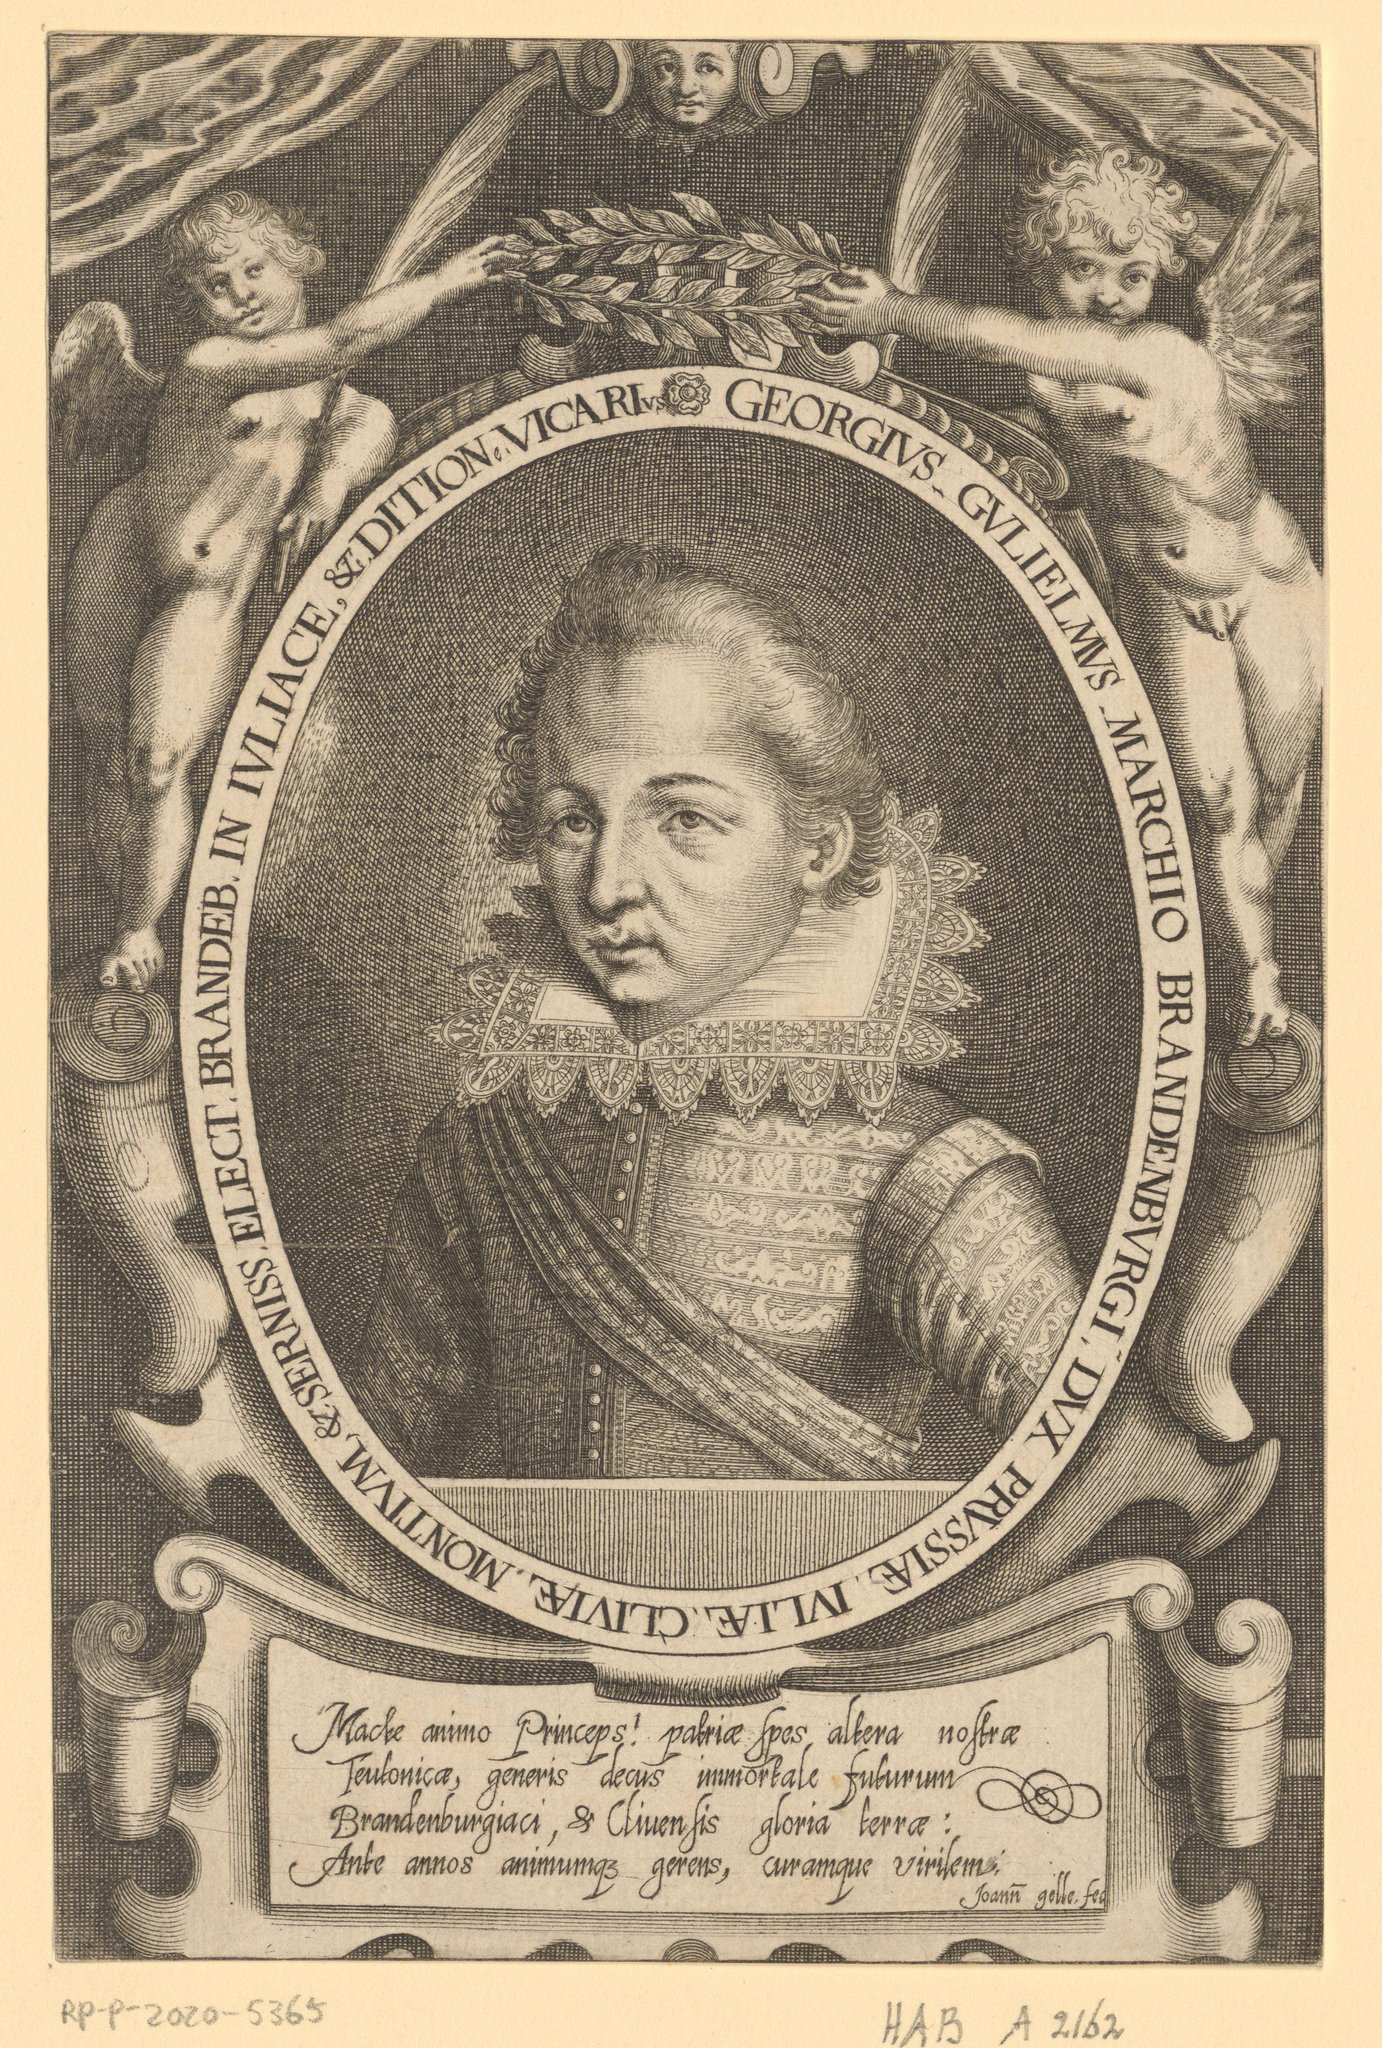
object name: print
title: Portret van Georg Wilhelm van Brandenburg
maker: johann gelle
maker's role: print maker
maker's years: 1585-1625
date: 1600-1625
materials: paper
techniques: engraving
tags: cologne, historical persons, cupids: 'amores', 'amoretti', 'putti'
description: Tekst in het Latijn in de ondermarge en in de omlijsting.